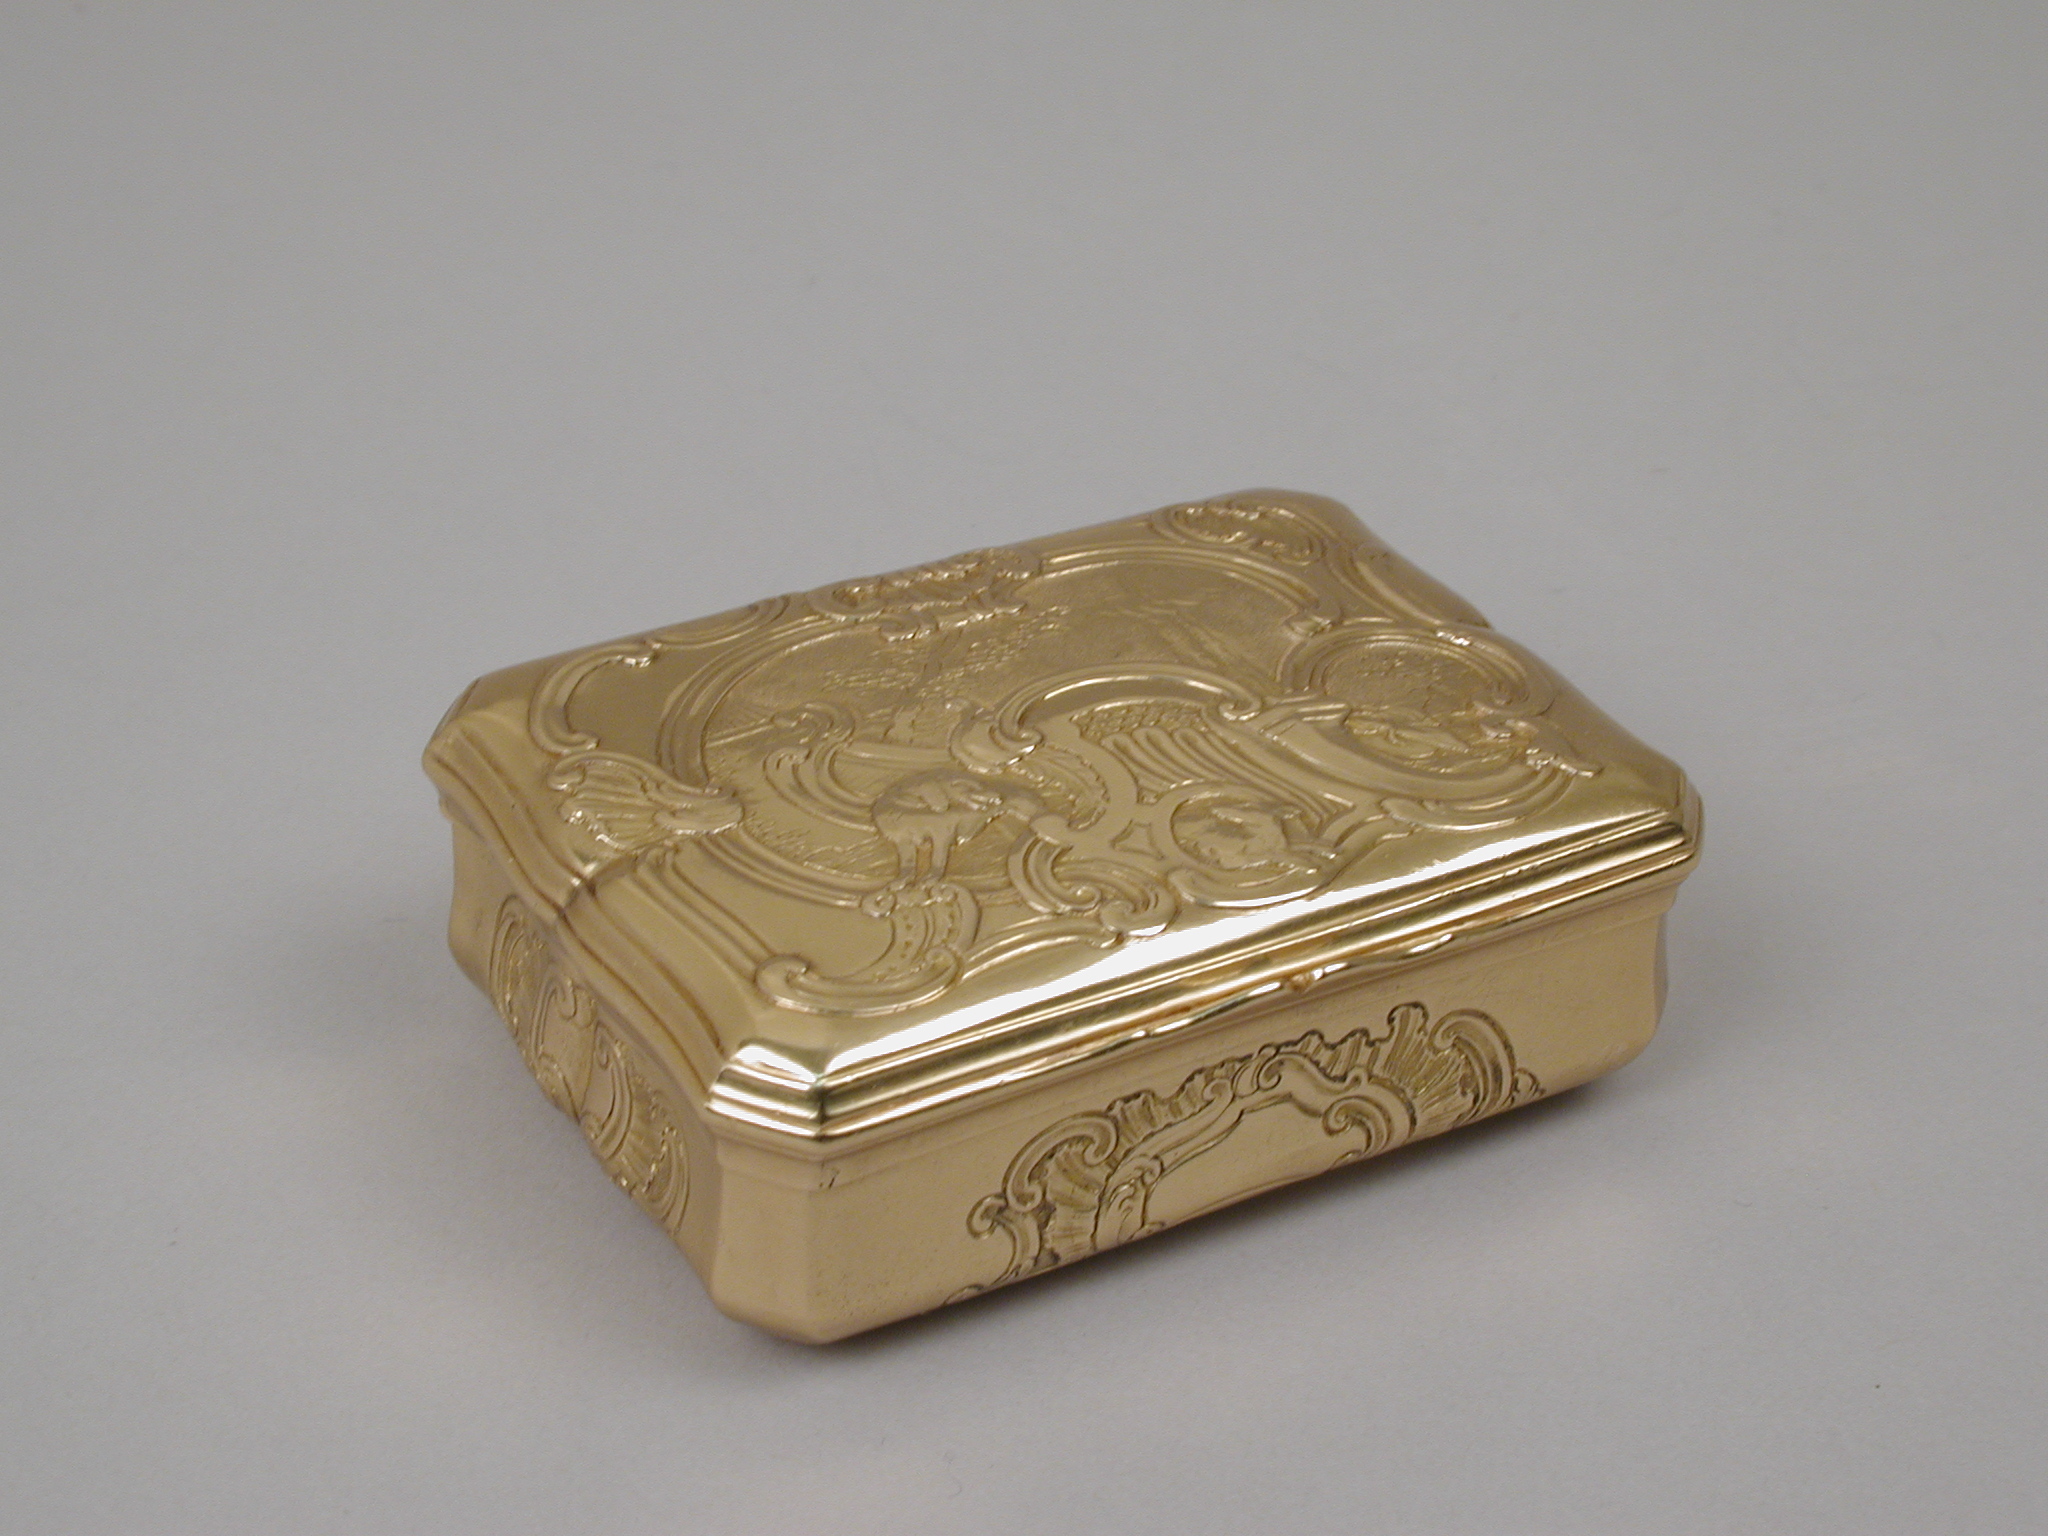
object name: box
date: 1736-1738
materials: gold